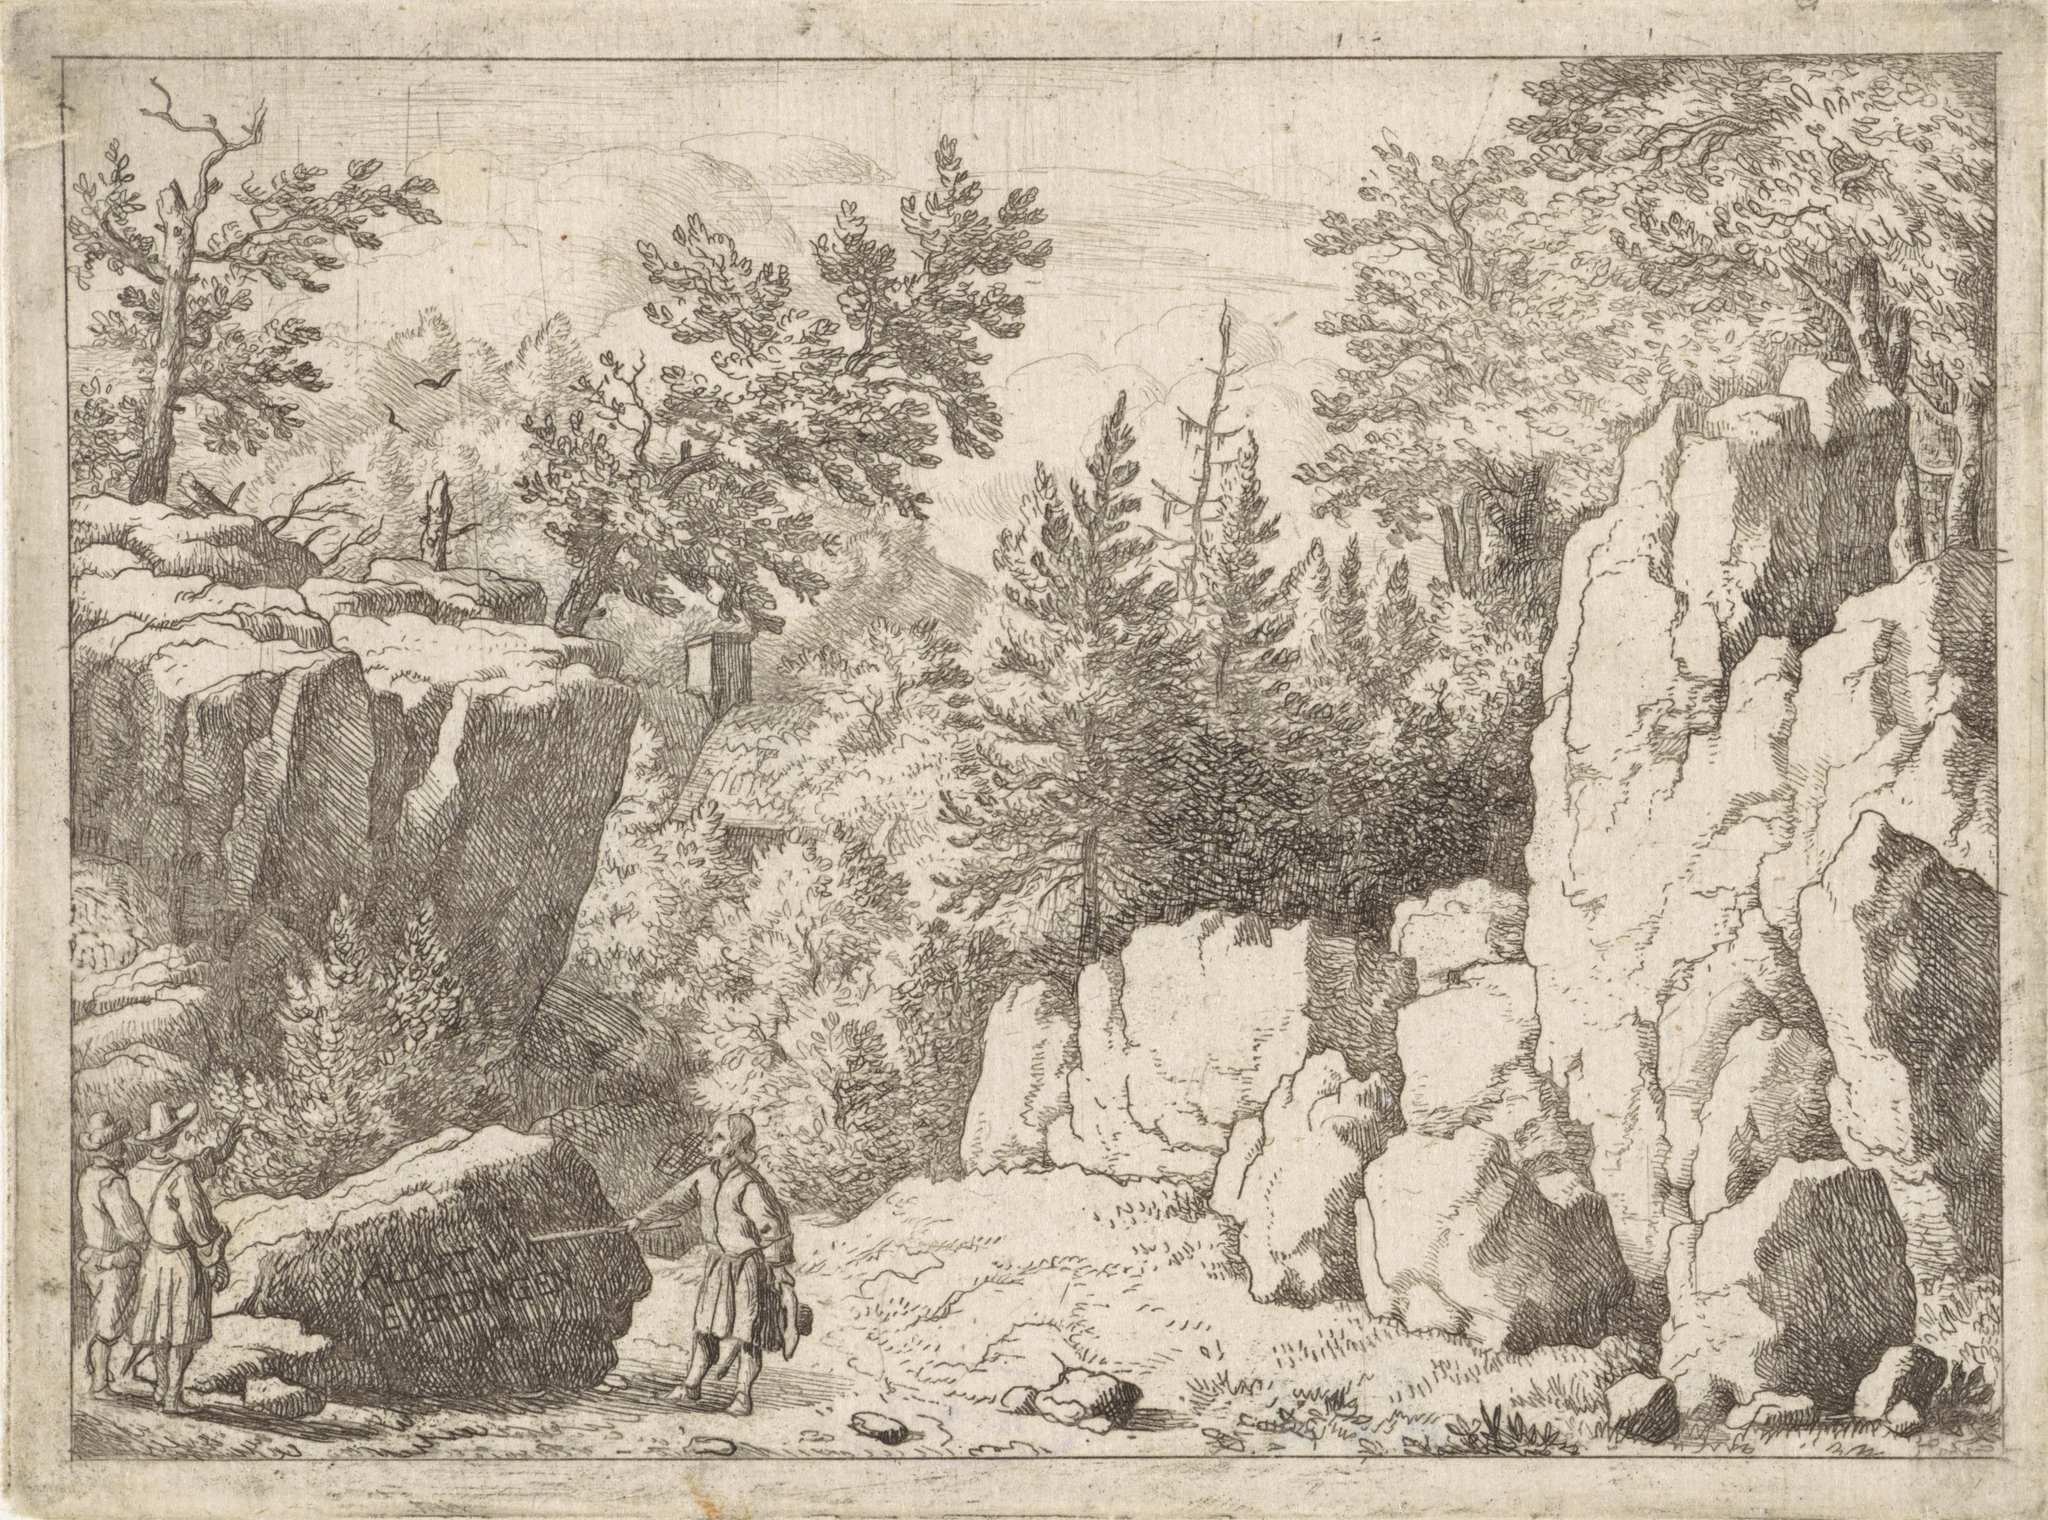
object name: print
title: Landschap met man met aanwijsstok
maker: allaert van everdingen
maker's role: draughtsman, painter, print maker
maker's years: 1621-1675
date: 1651-1675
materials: paper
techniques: etching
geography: netherlands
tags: rocks (+ landscape with figures, staffage)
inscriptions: collector's mark: Lugt 2228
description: In een rotsachtig landschap staan drie mannen bij een steen; één van hen wijst met een stok de inscriptie aan.